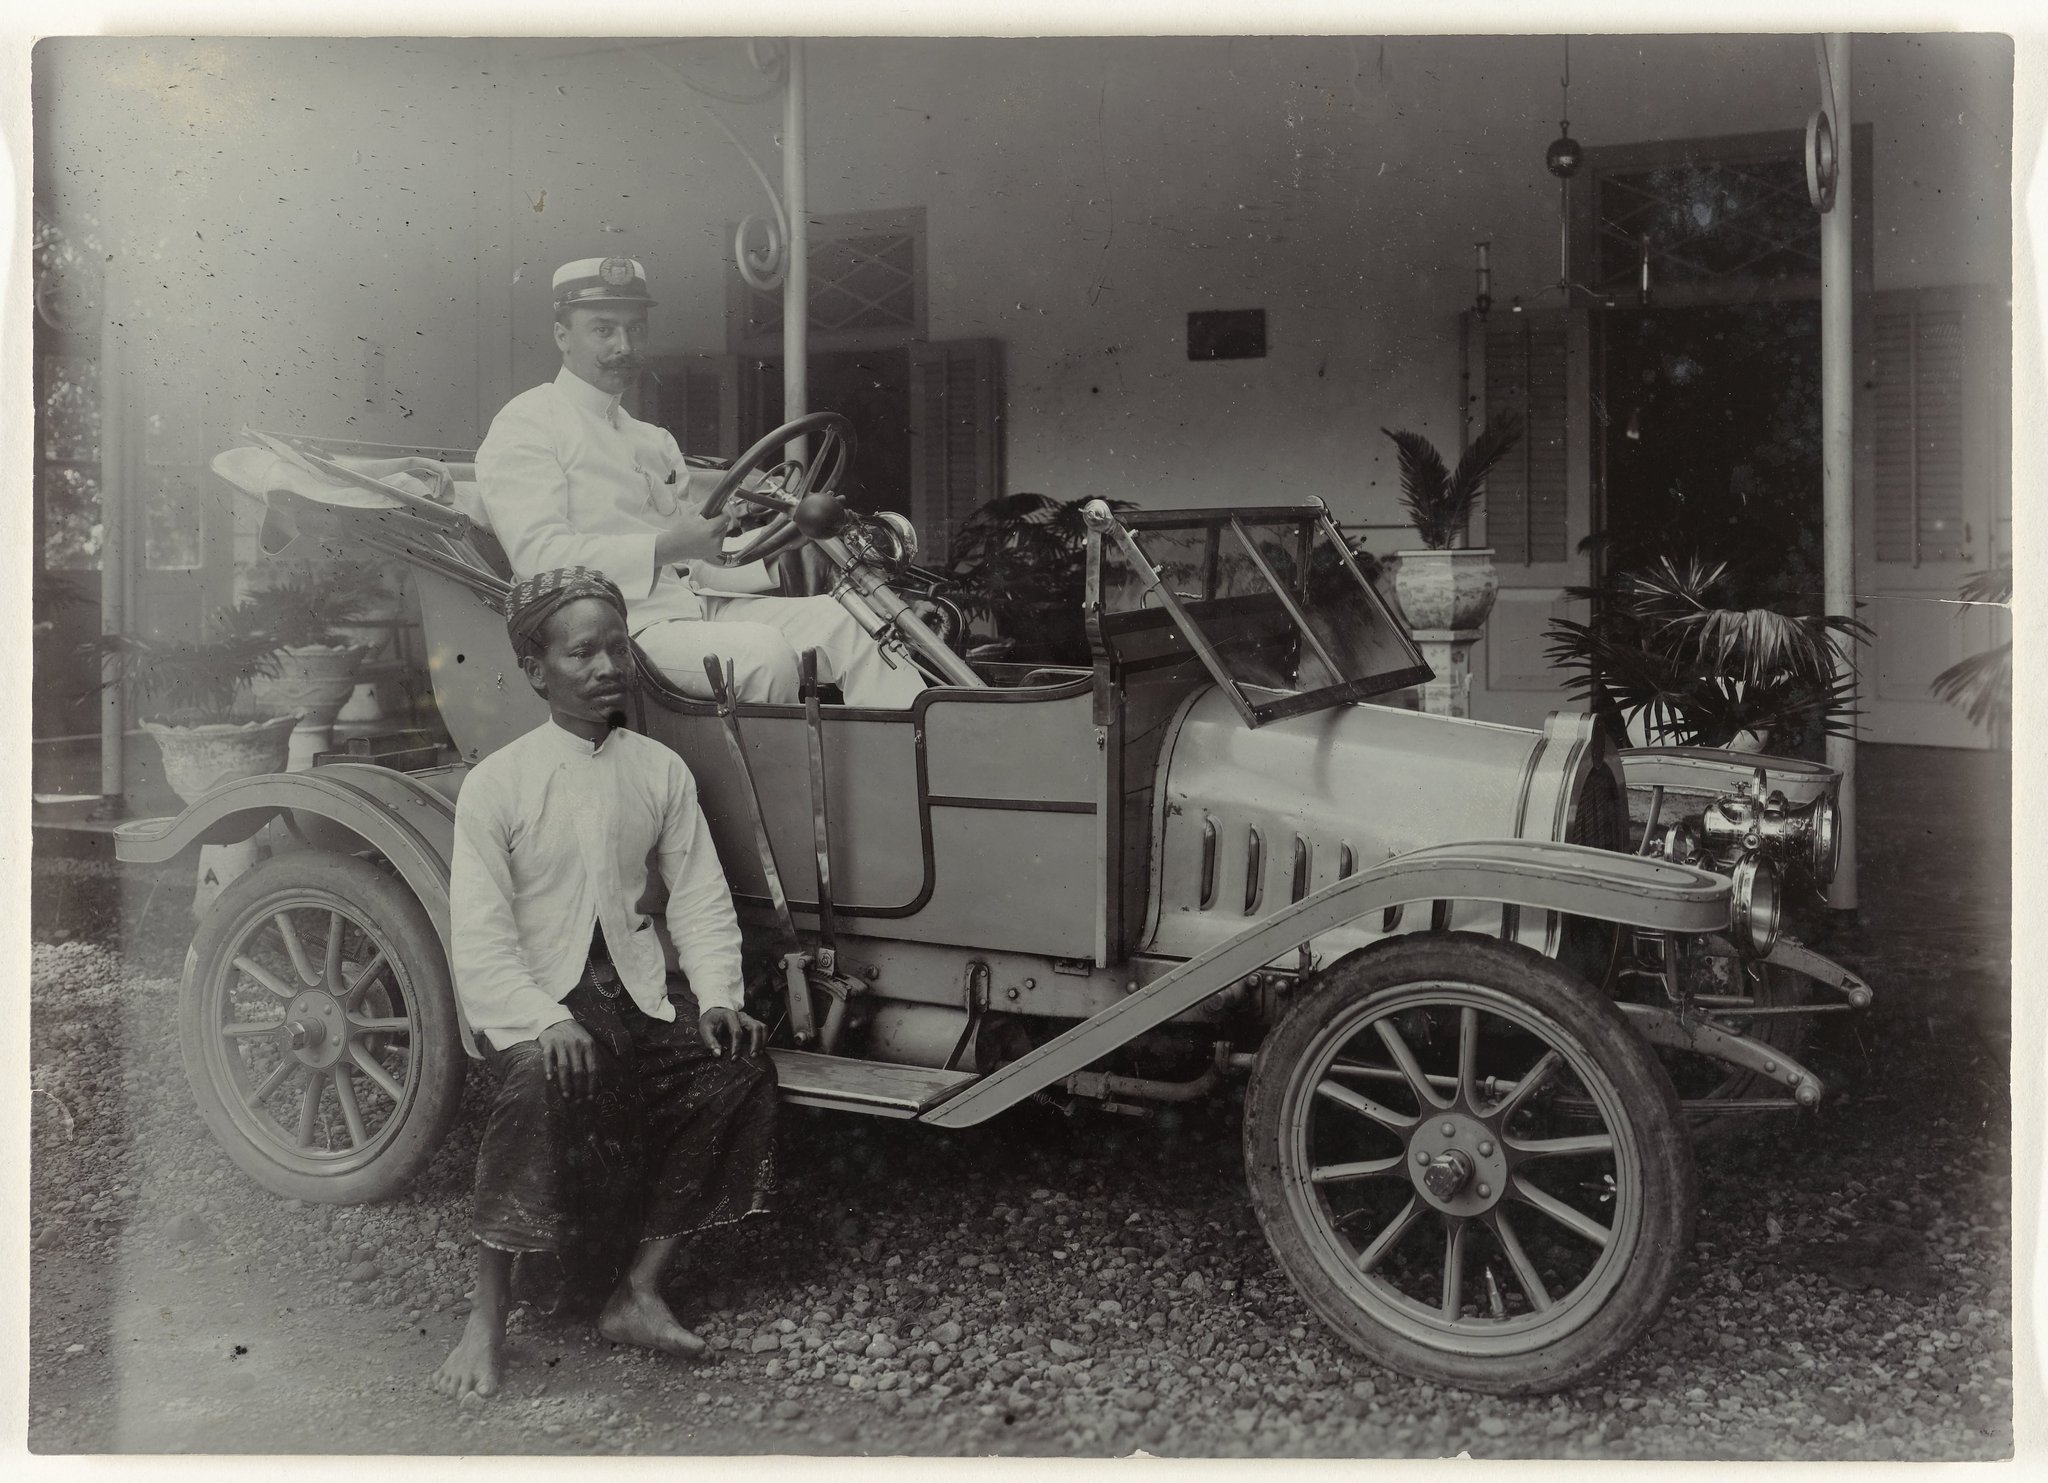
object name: photograph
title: De heer Letterie in zijn auto met bediende voor zijn woning in Mojosari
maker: Anonymous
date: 1913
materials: photographic support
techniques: photography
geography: mojosari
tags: automobile, house personnel, servants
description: De heer Letterie in zijn auto met bediende voor zijn woning in Mojosari in Indië.